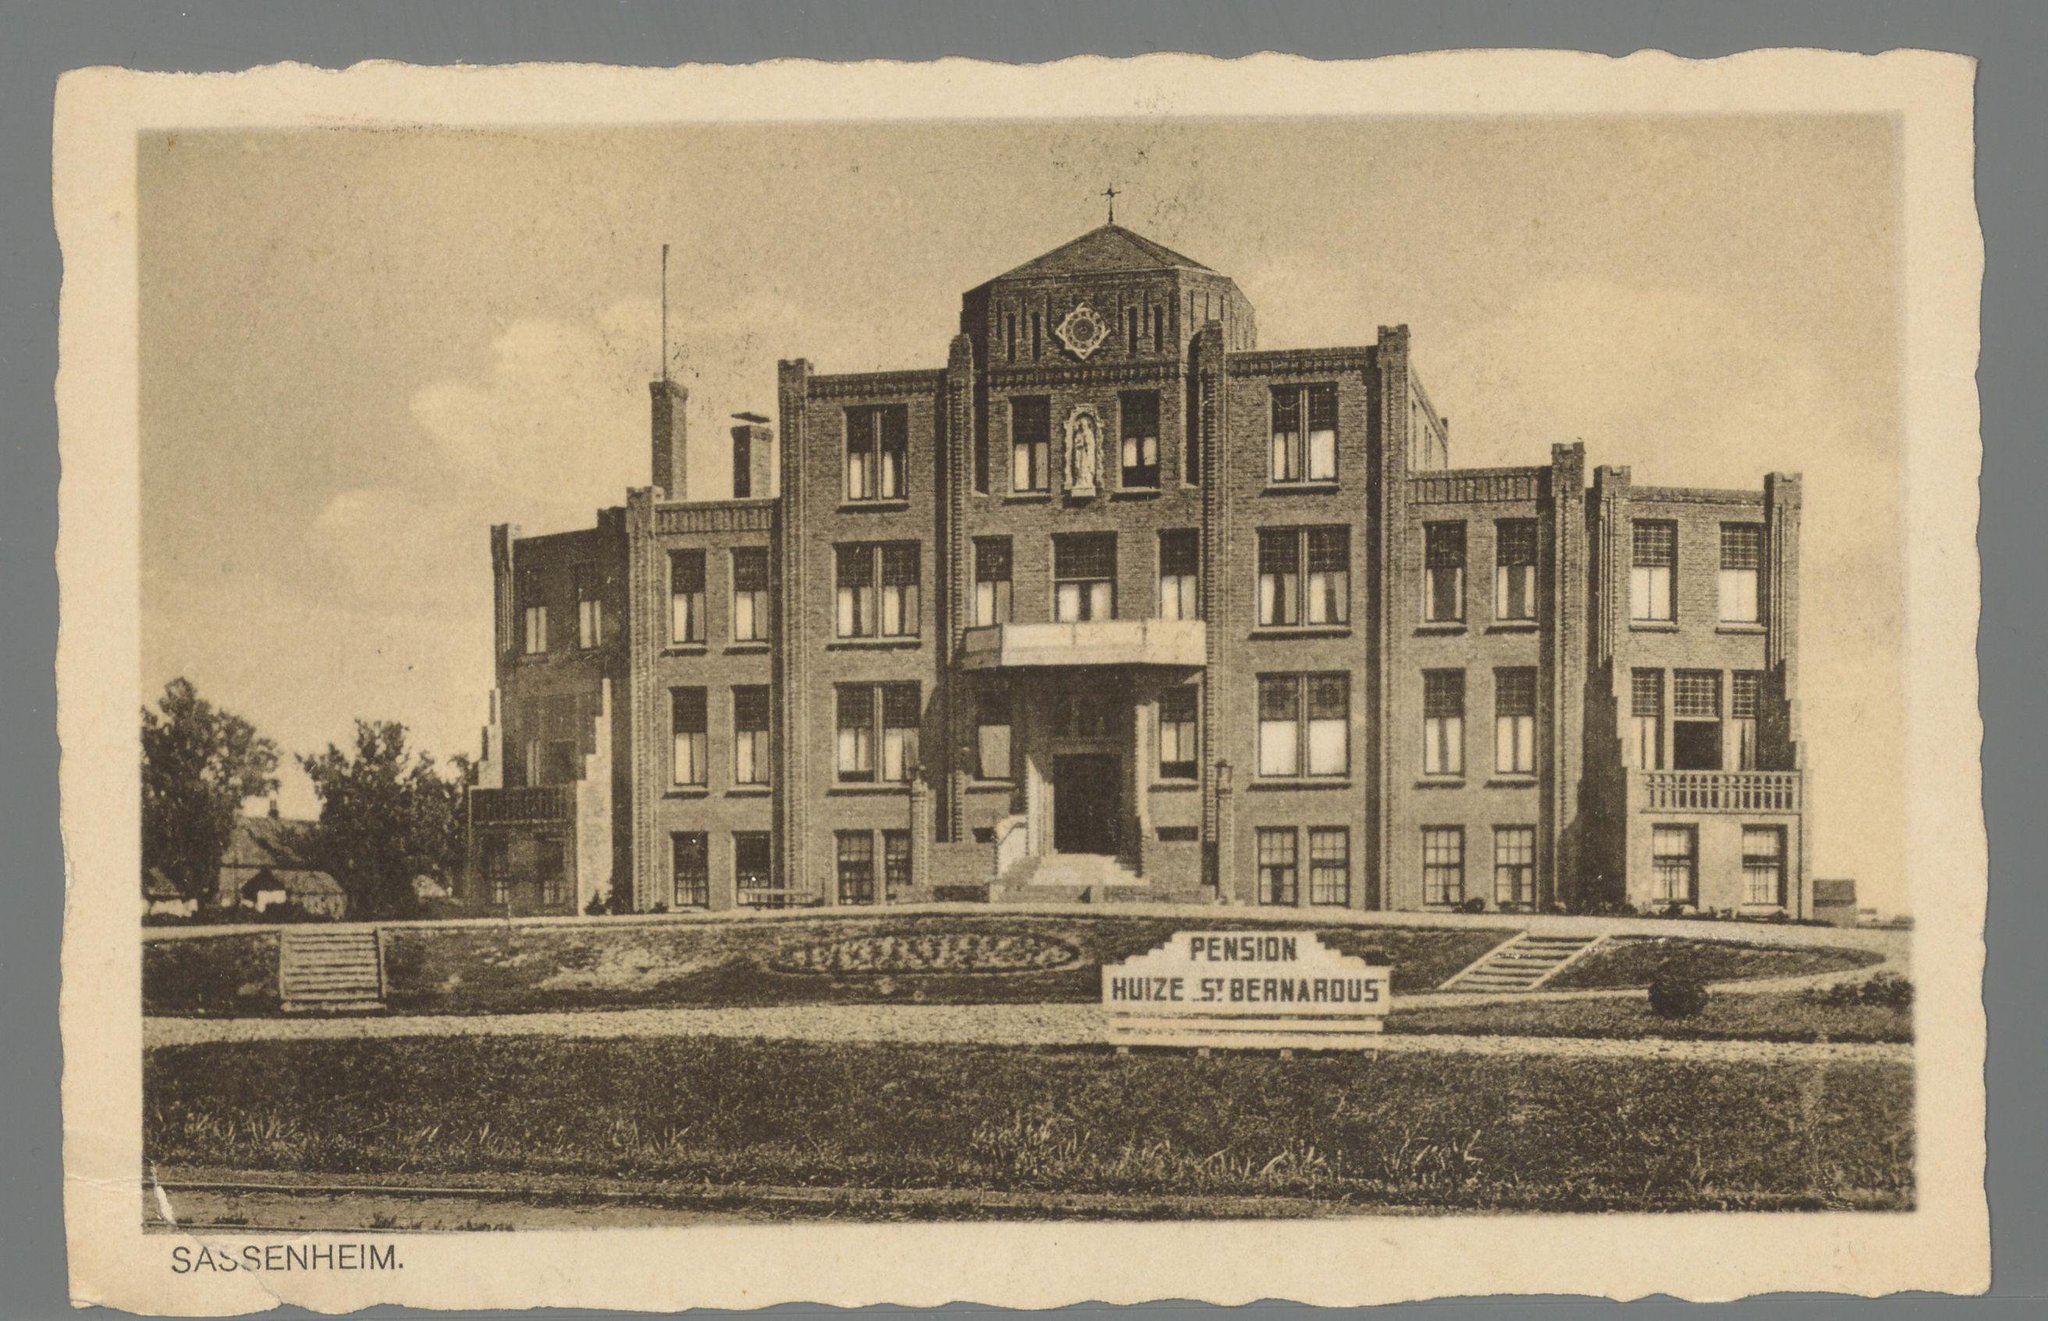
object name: ansichtkaart, prentbriefkaart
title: Sassenheim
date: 1924-1930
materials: cardboard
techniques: photograph, writing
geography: sassenheim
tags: hotel, hostelry, inn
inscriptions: poststempel, verso, gestempeld